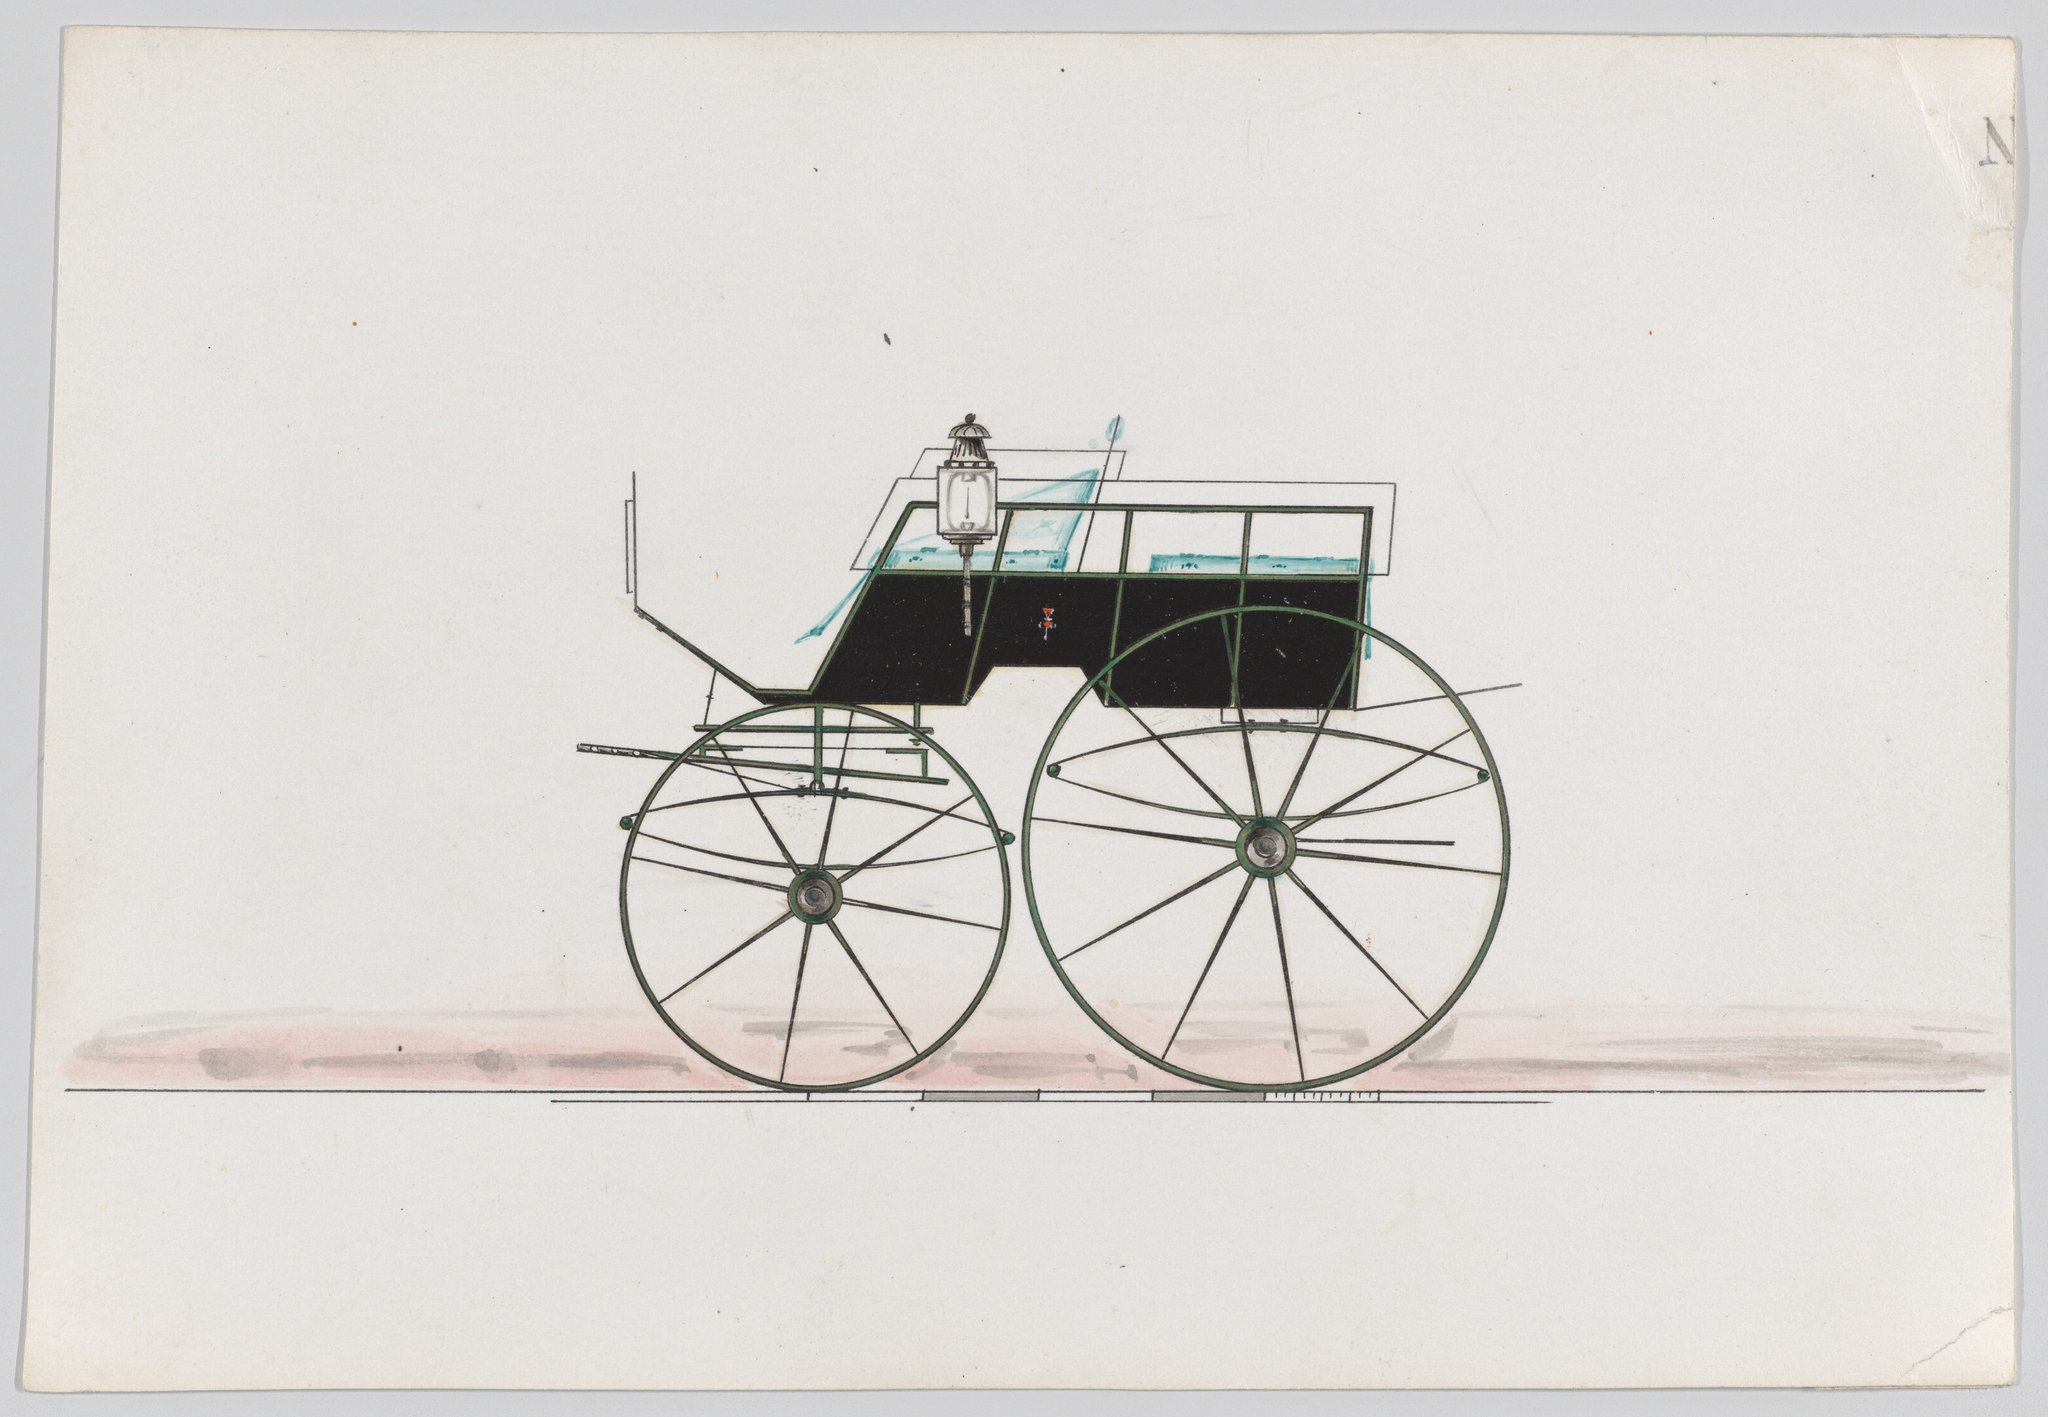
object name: drawing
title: Design for Game Wagon/Dos-à-dos Phaeton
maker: brewster & co.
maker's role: manufacturer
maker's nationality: american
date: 1850-1870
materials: gouache, gum arabic, ink, watercolor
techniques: pen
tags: carriages